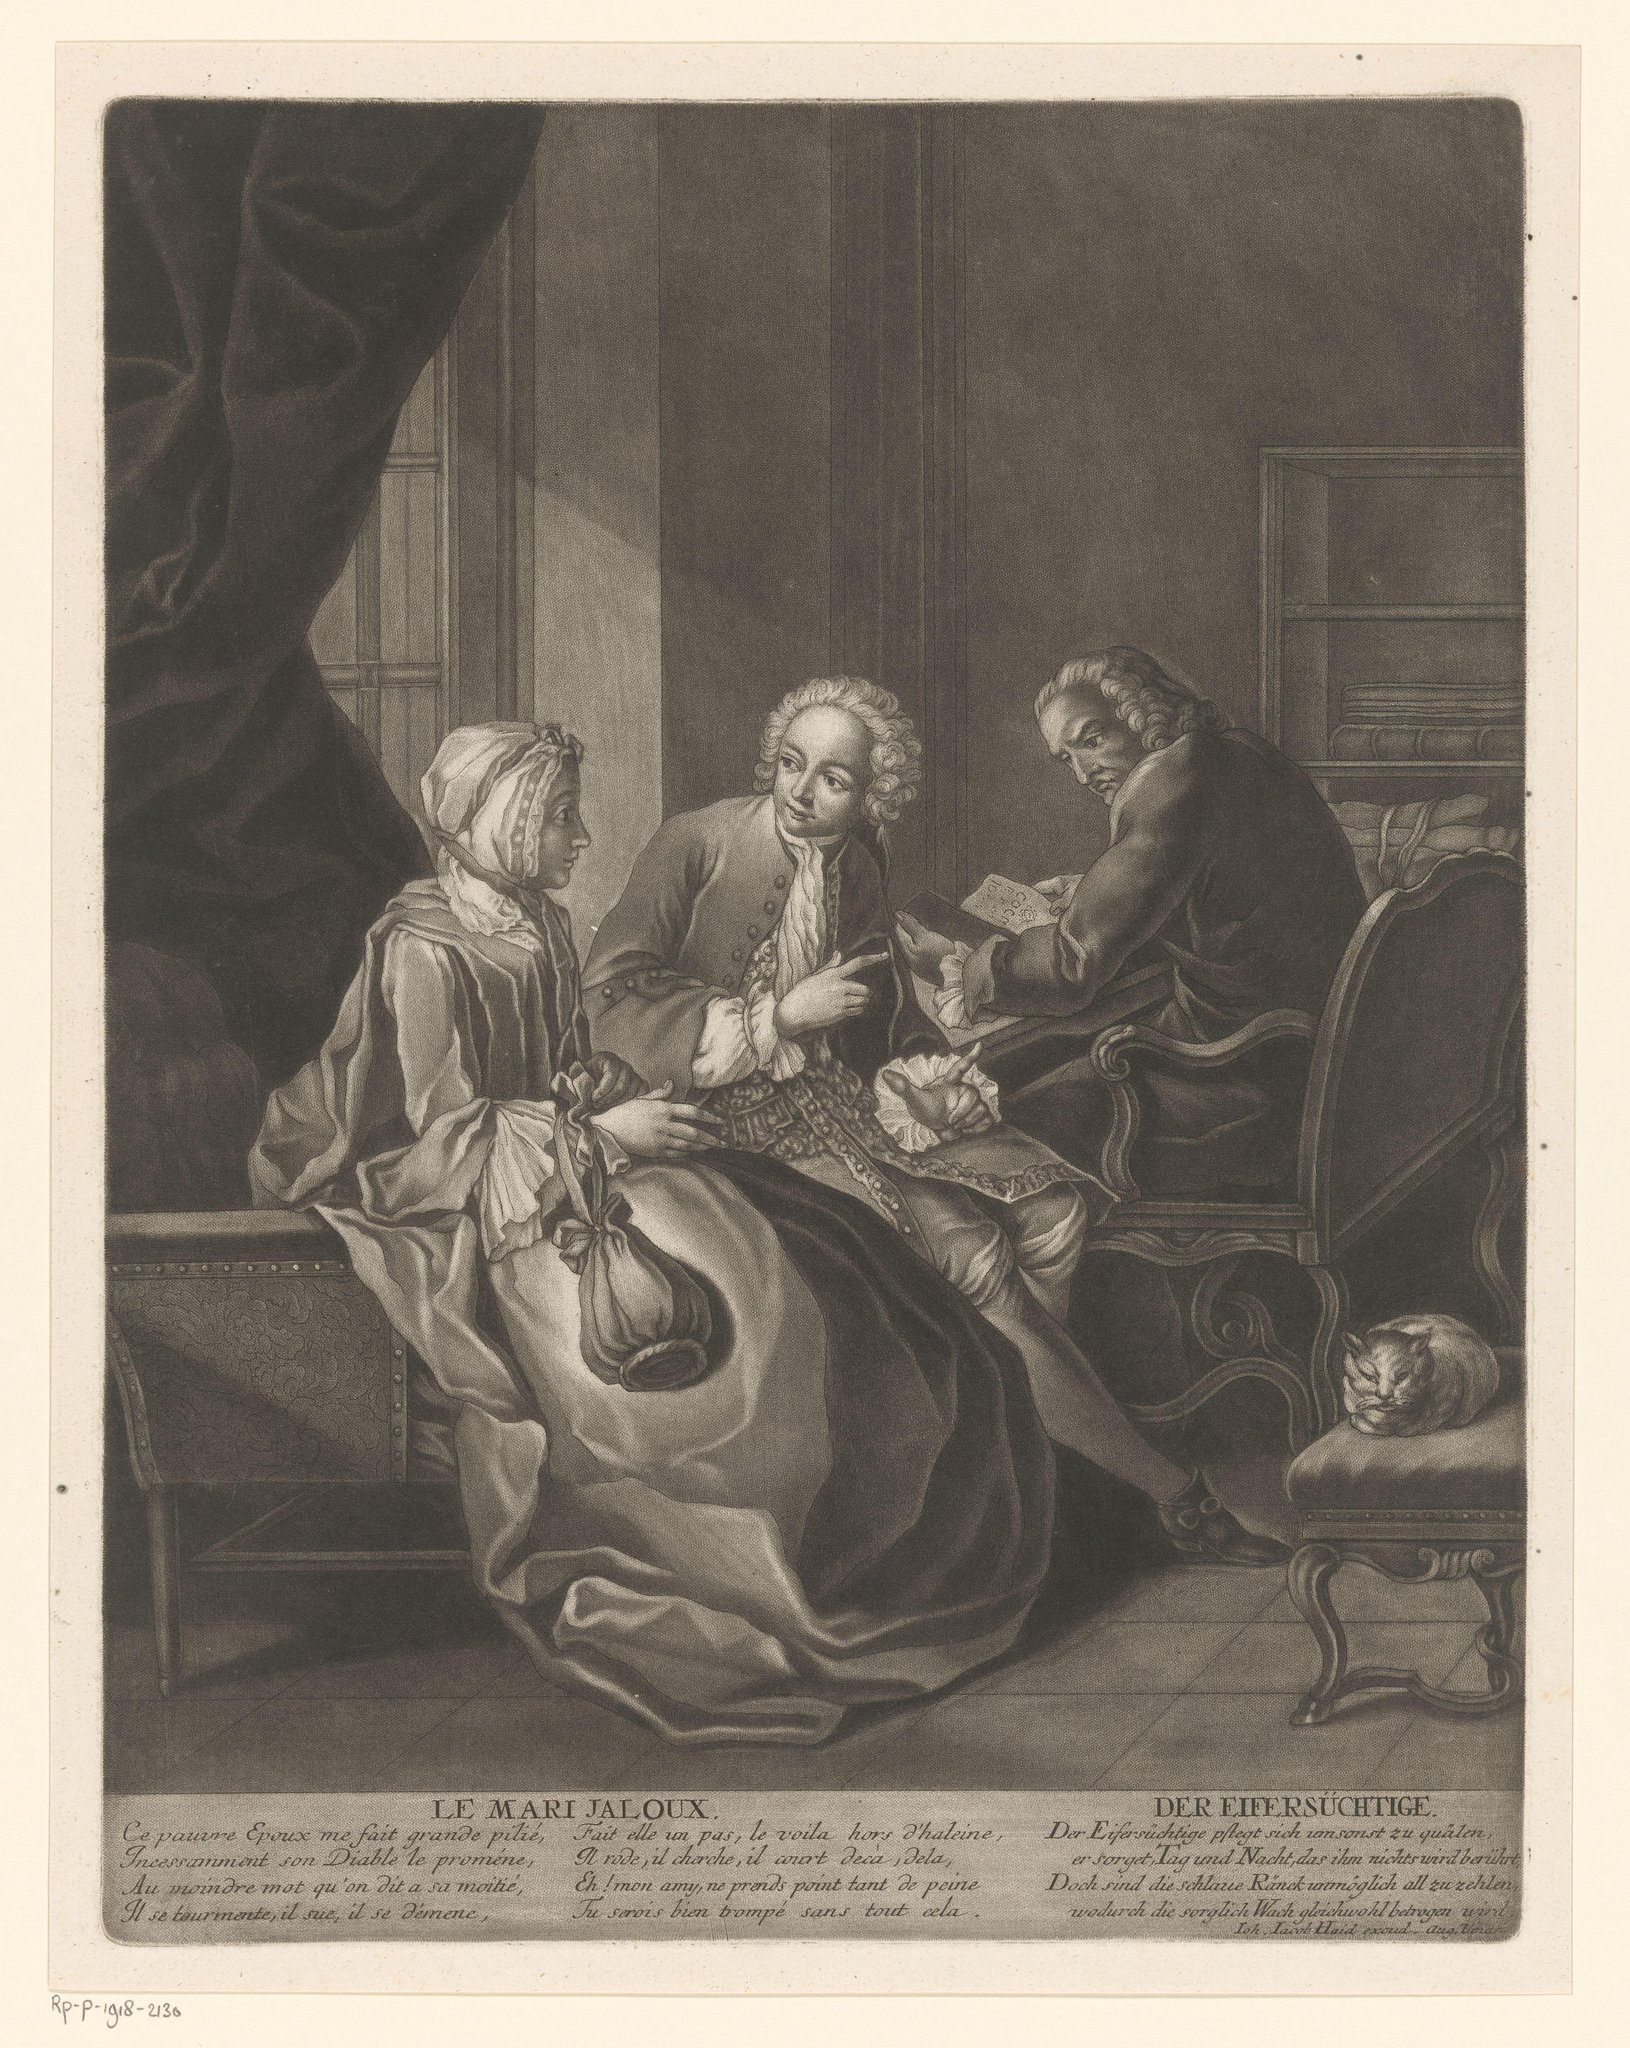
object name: print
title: Le mari jaloux / Der Eifersüchtige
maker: johann jacob haid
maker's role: print maker, publisher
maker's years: 1704-1767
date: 1714-1767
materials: paper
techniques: etching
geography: augsburg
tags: marriage, married couple, 'matrimonium', jealousy; 'gelosia', 'rammarico del ben'altrui' (ripa)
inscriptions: collector's mark: Lugt 2233